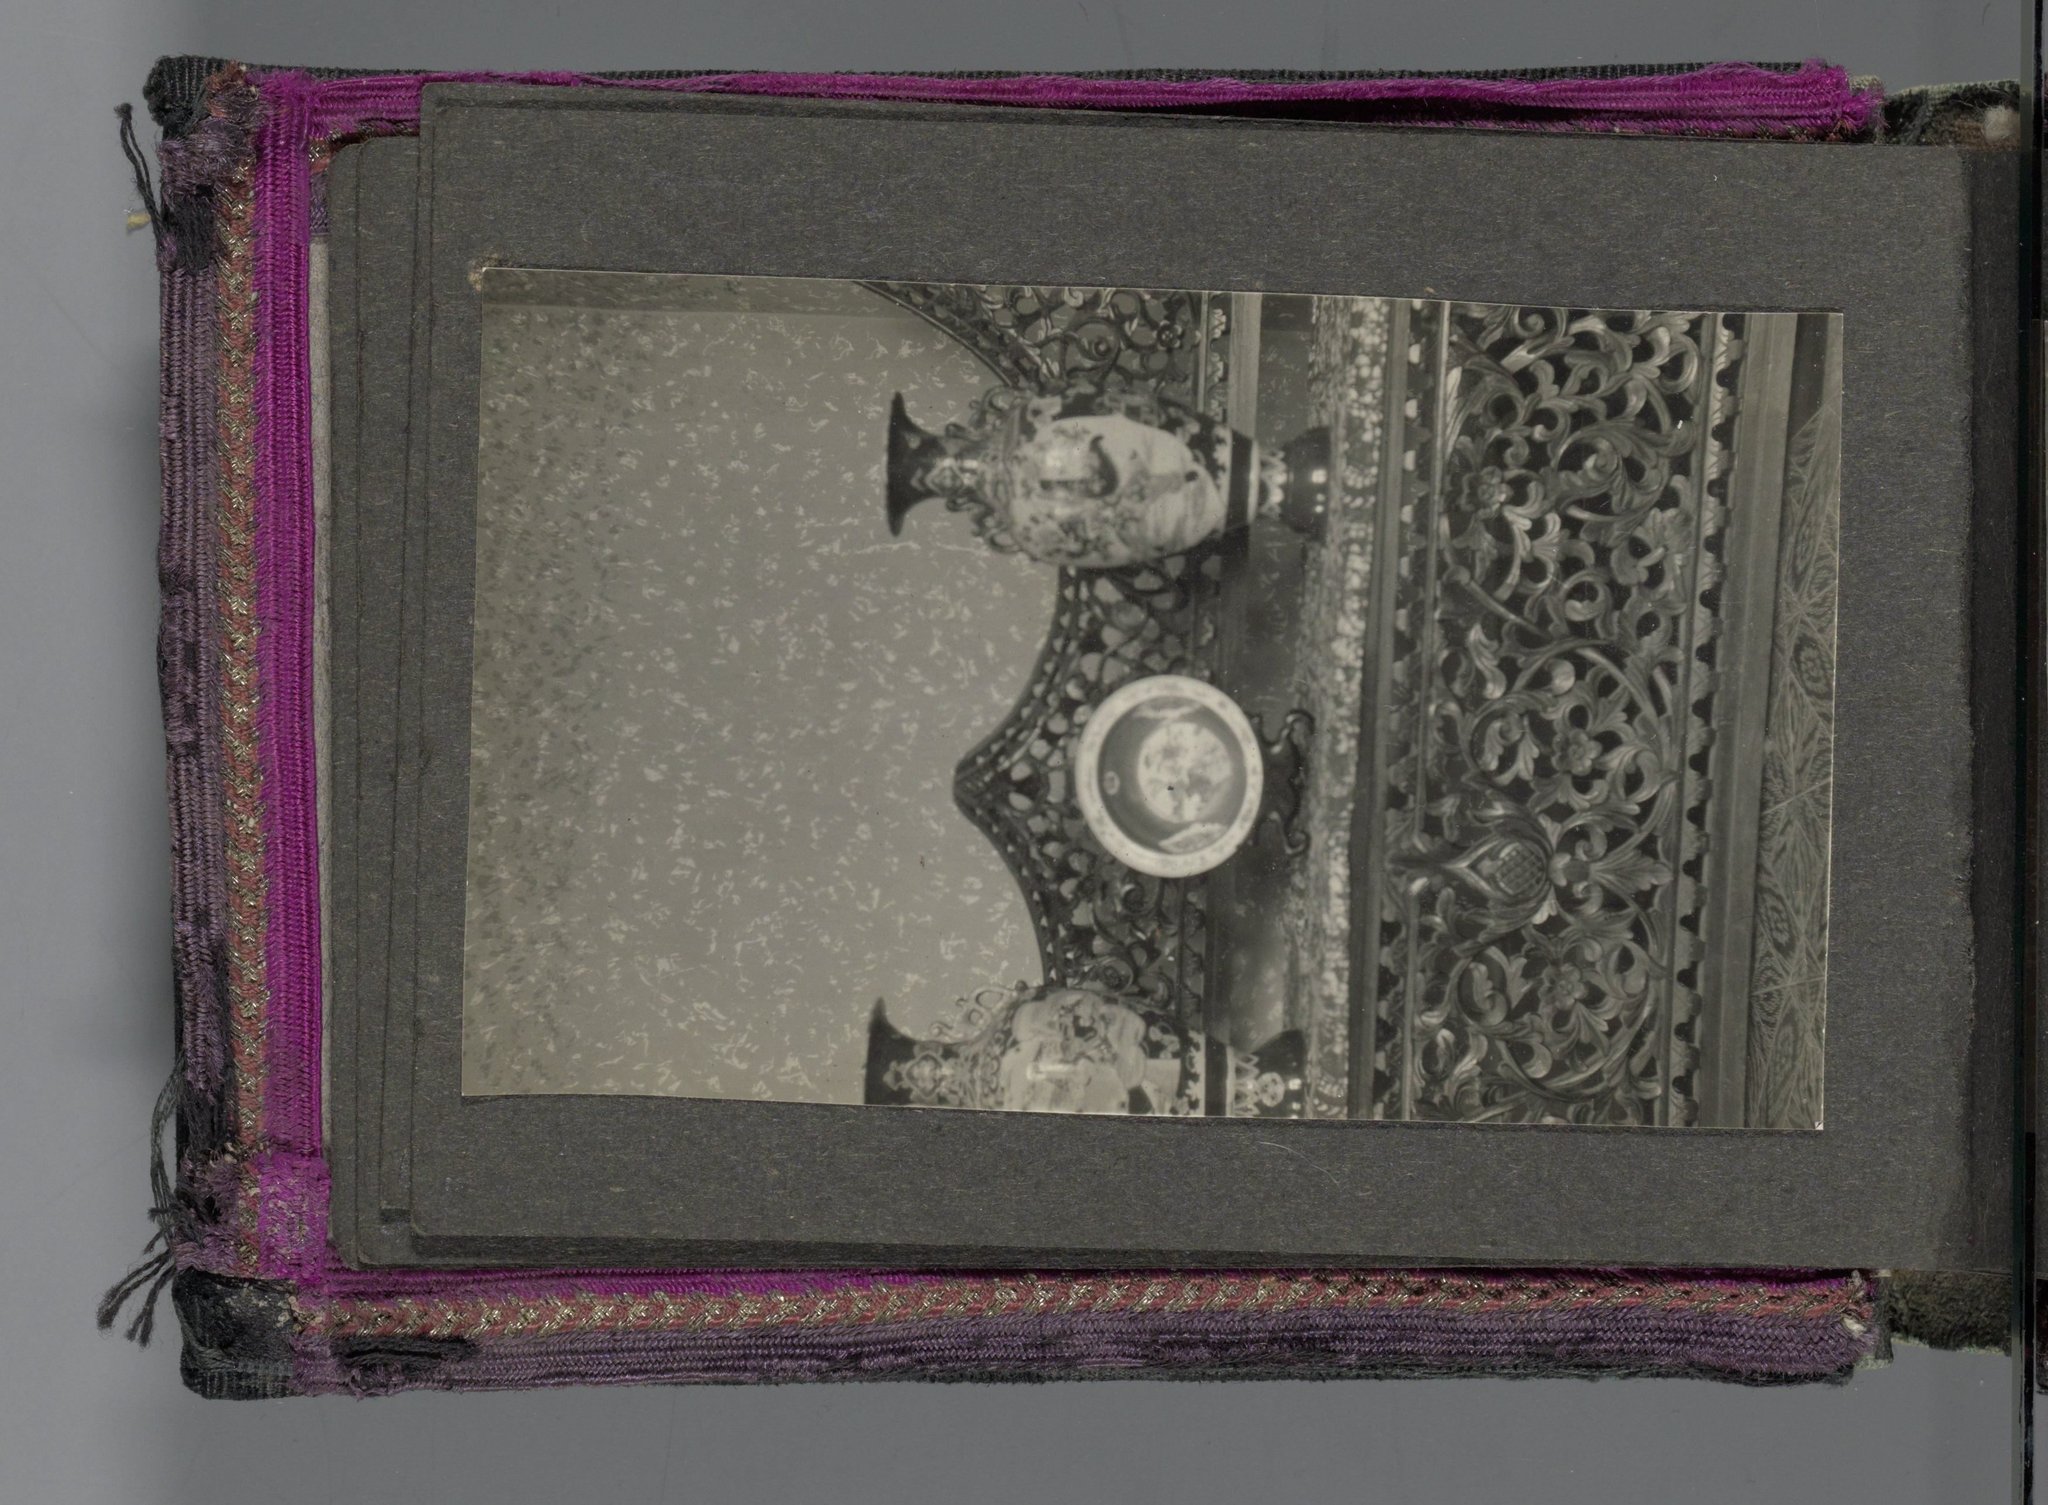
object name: photograph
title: Chinese vazen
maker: elsa silberstein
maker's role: amateurfotograaf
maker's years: -2006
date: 1935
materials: photographic support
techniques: gelatin silver print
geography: bandung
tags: amsterdam, elsa silberstein, interior of the house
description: Twee Chinese vazen en een kom. In het woonhuis van Elsa Silberstein en haar man, thesaurier-generaal in Bandung in 1935. Schilderijtjes aan de muur. Onderdeel van het fotoalbum met zwart-wit foto's van het interieur van het huis van de familie Silberstein in Bandung in Nederlands-Indië.